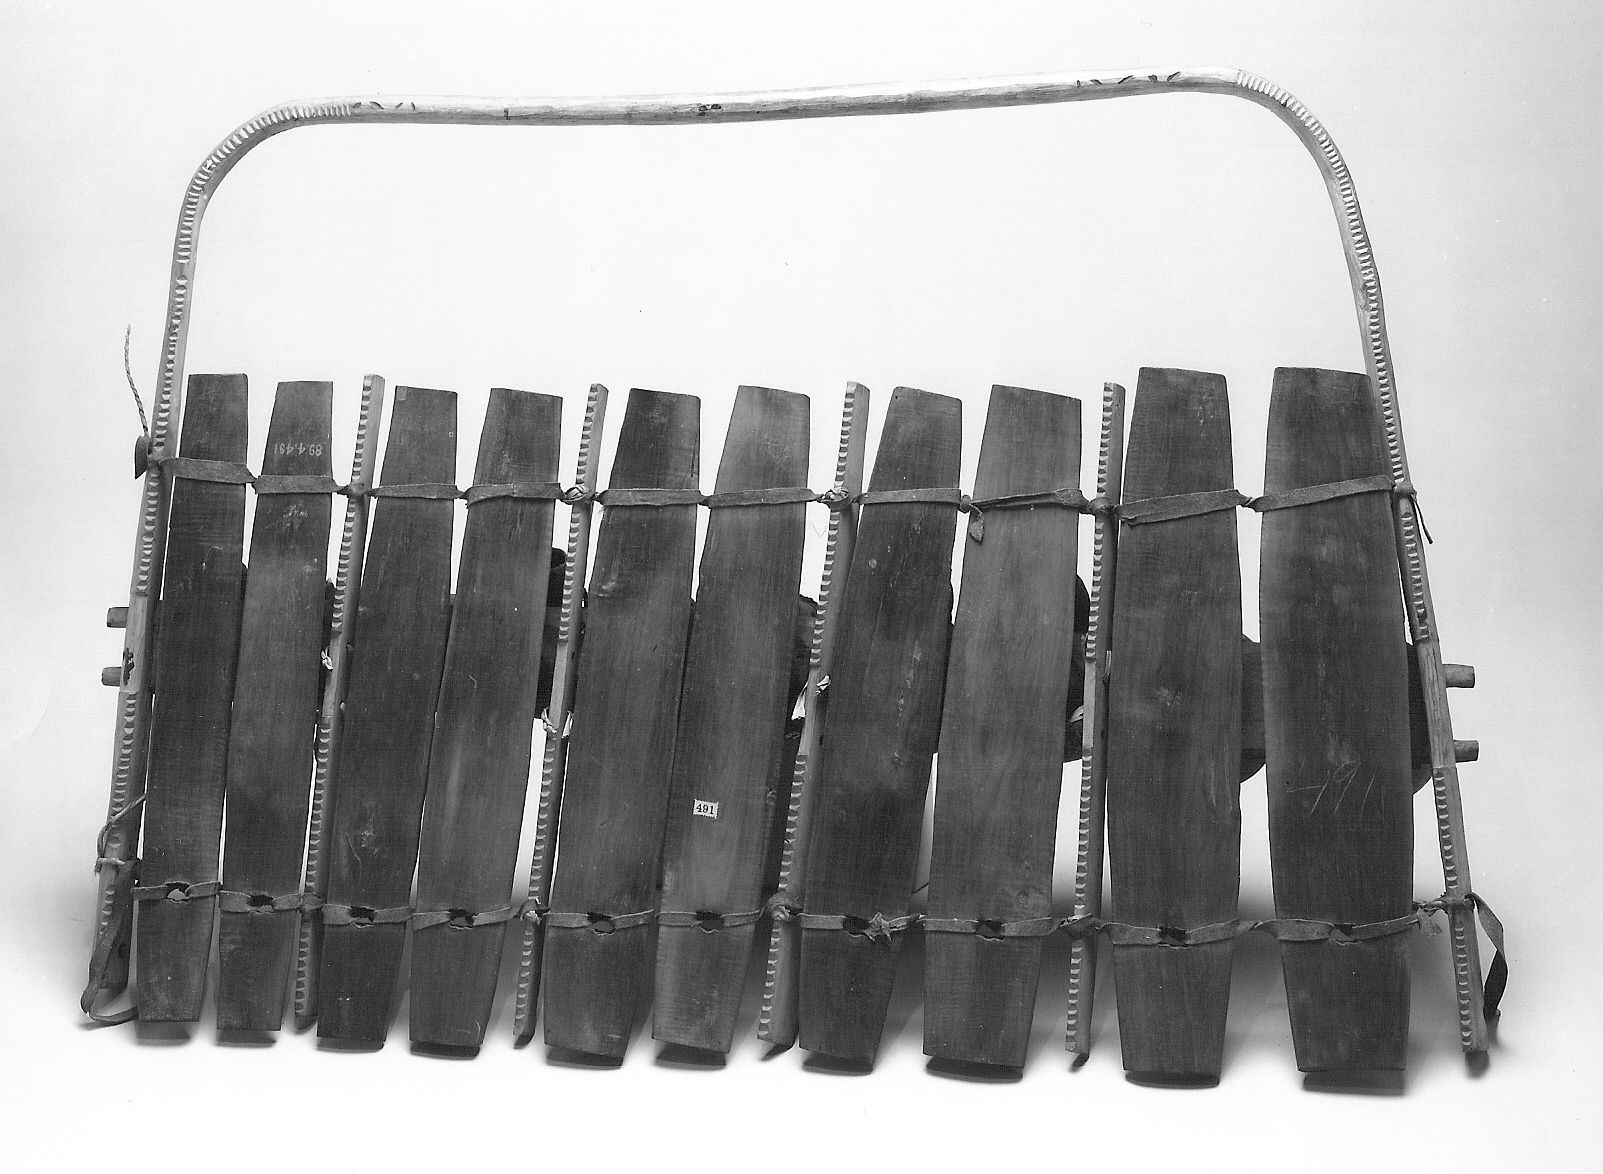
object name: mbila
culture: chopi people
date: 1801-1900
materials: leather, skin, wood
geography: mozambique